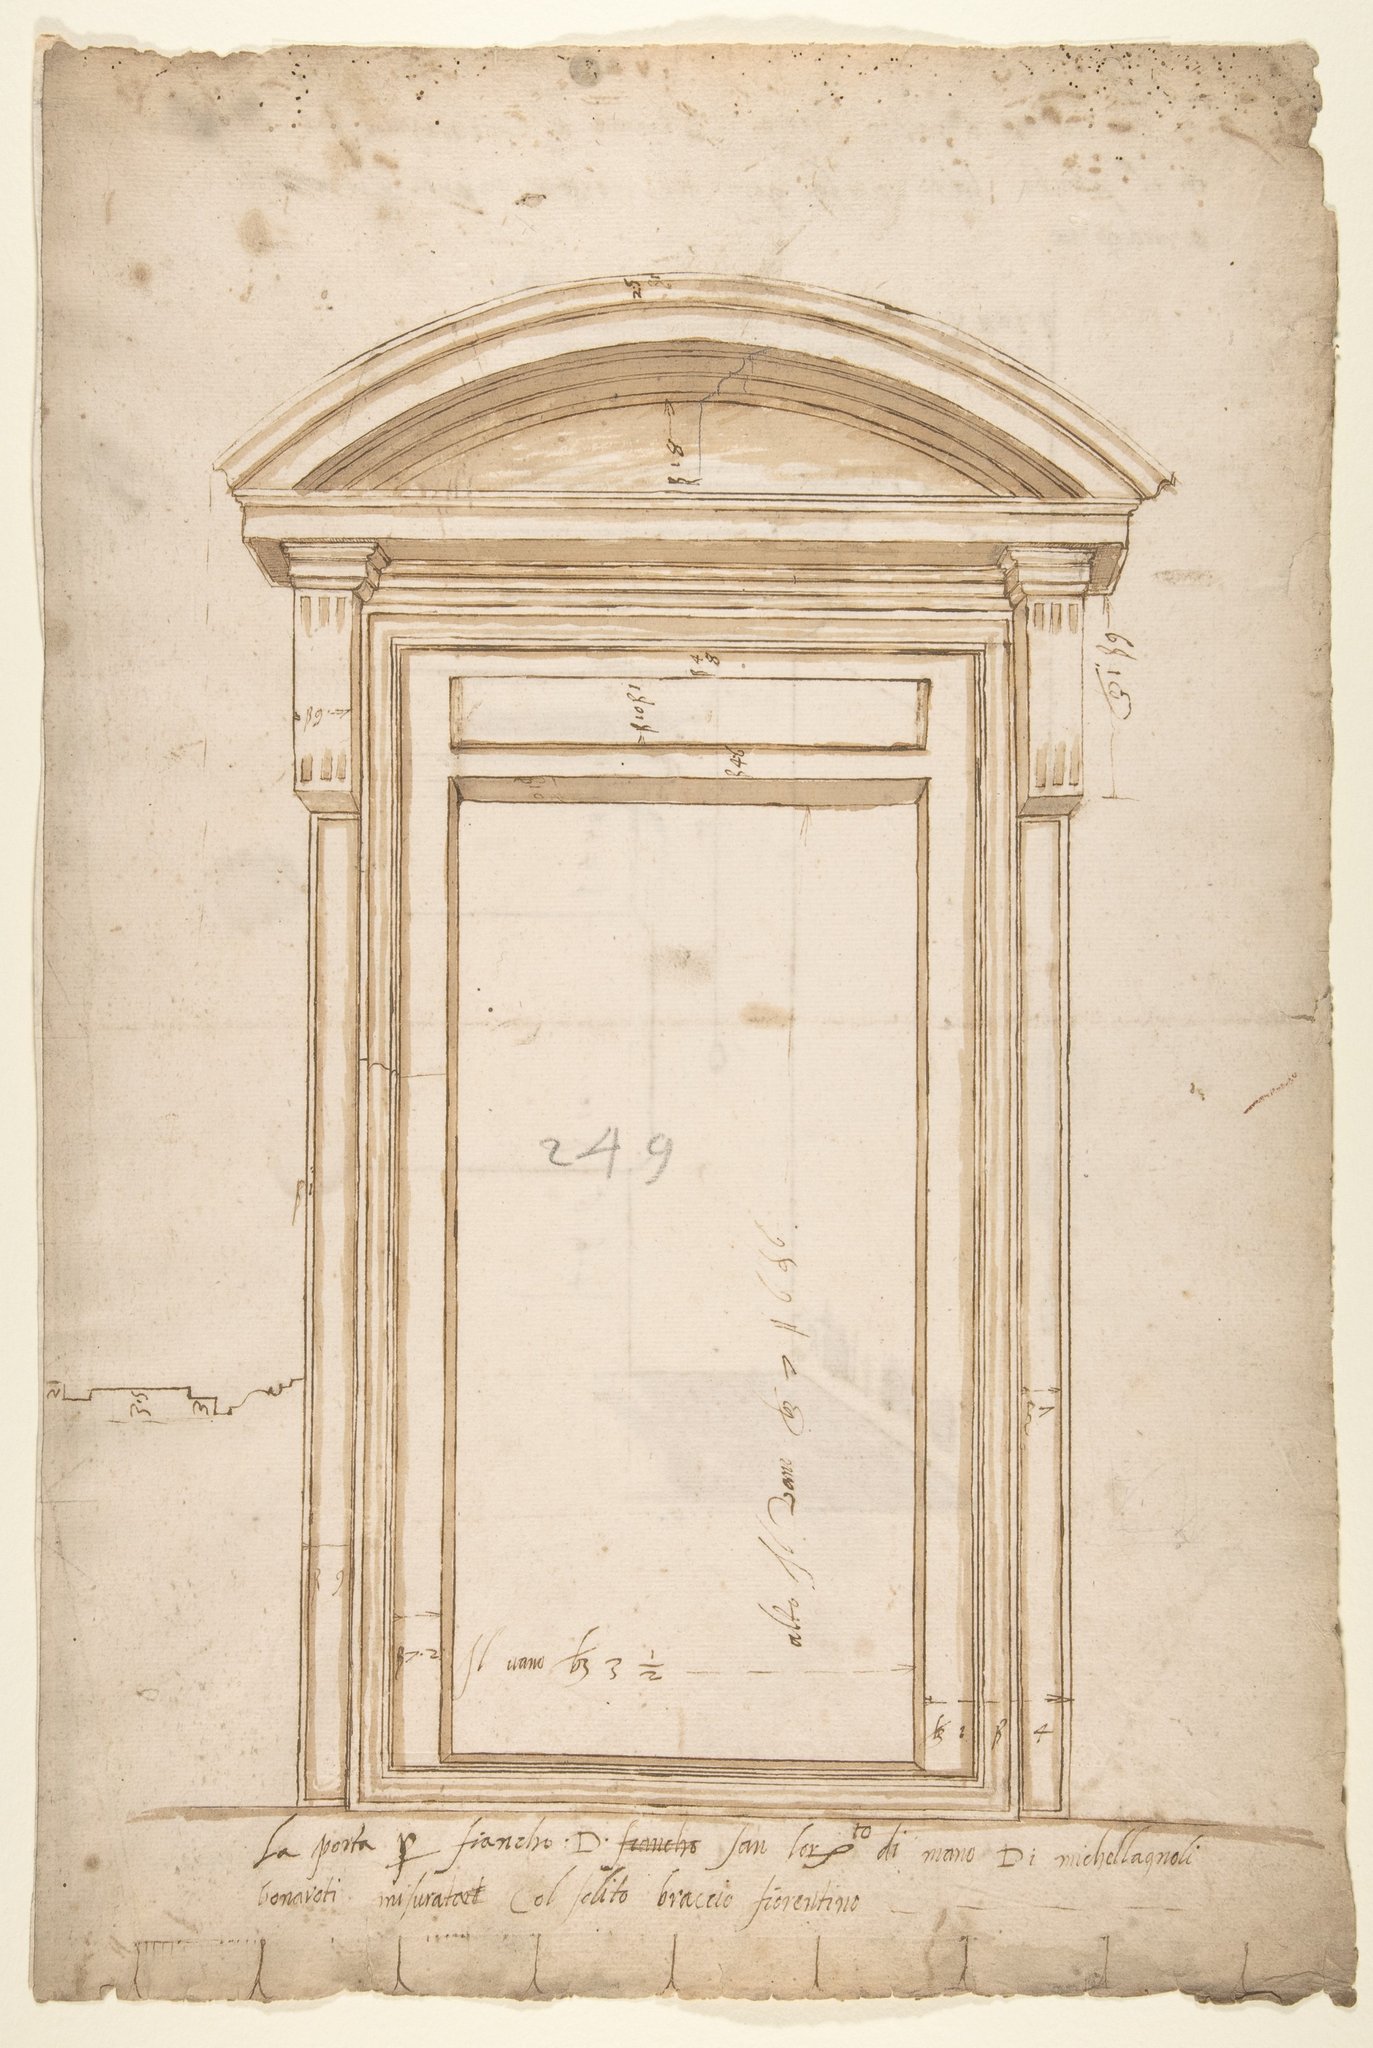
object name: drawing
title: San Lorenzo, north portal, elevation (recto) San Lorenzo, north portal, cornice, profile (verso)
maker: anonymous, french, 16th century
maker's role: draftsman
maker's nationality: french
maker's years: 1500-1600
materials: chalk, ink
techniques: incising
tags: architecture